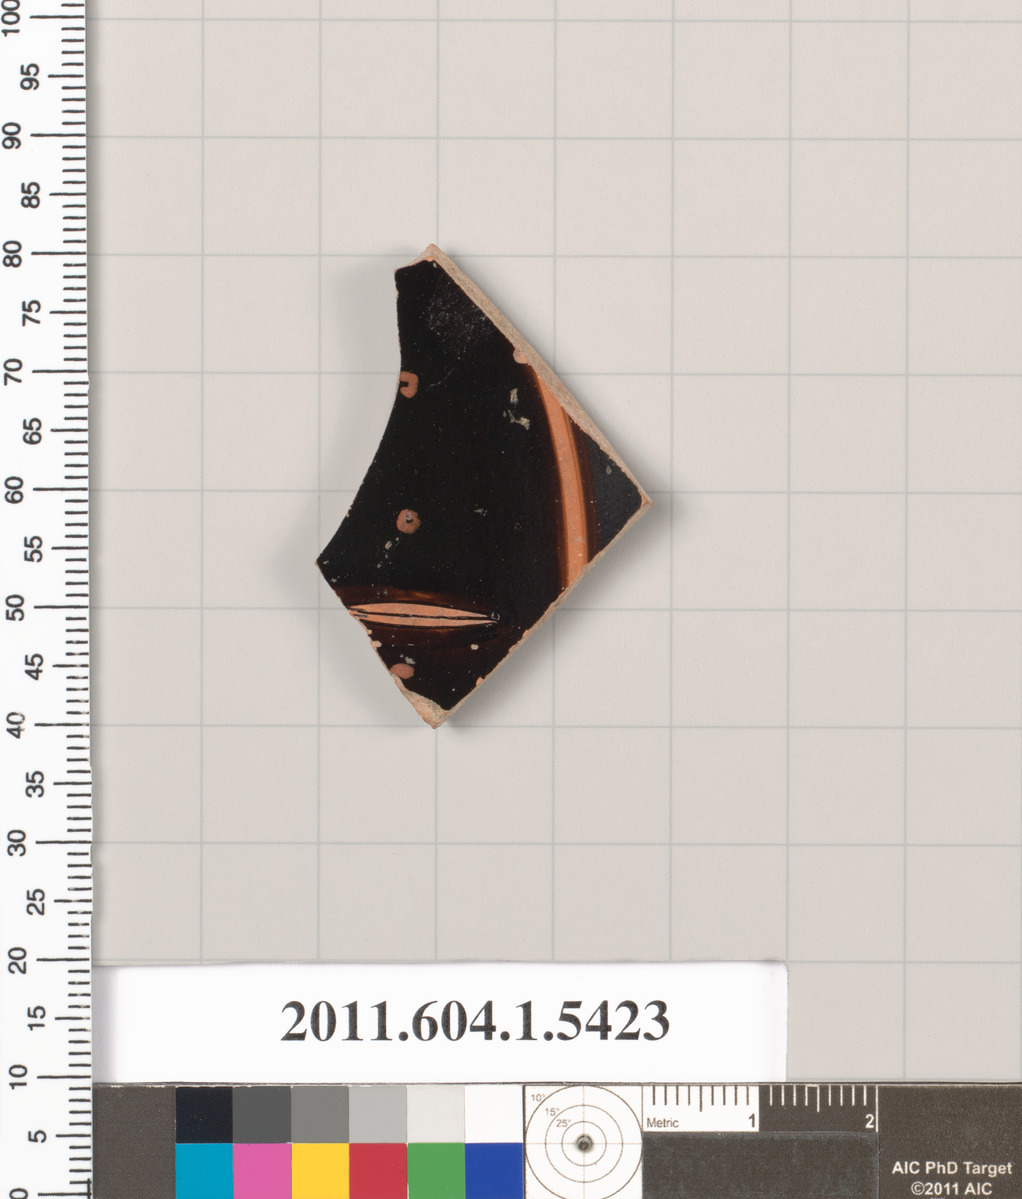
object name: kylix fragment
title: Terracotta fragment of a kylix (drinking cup)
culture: greek, attic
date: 500-480 BCE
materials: terracotta